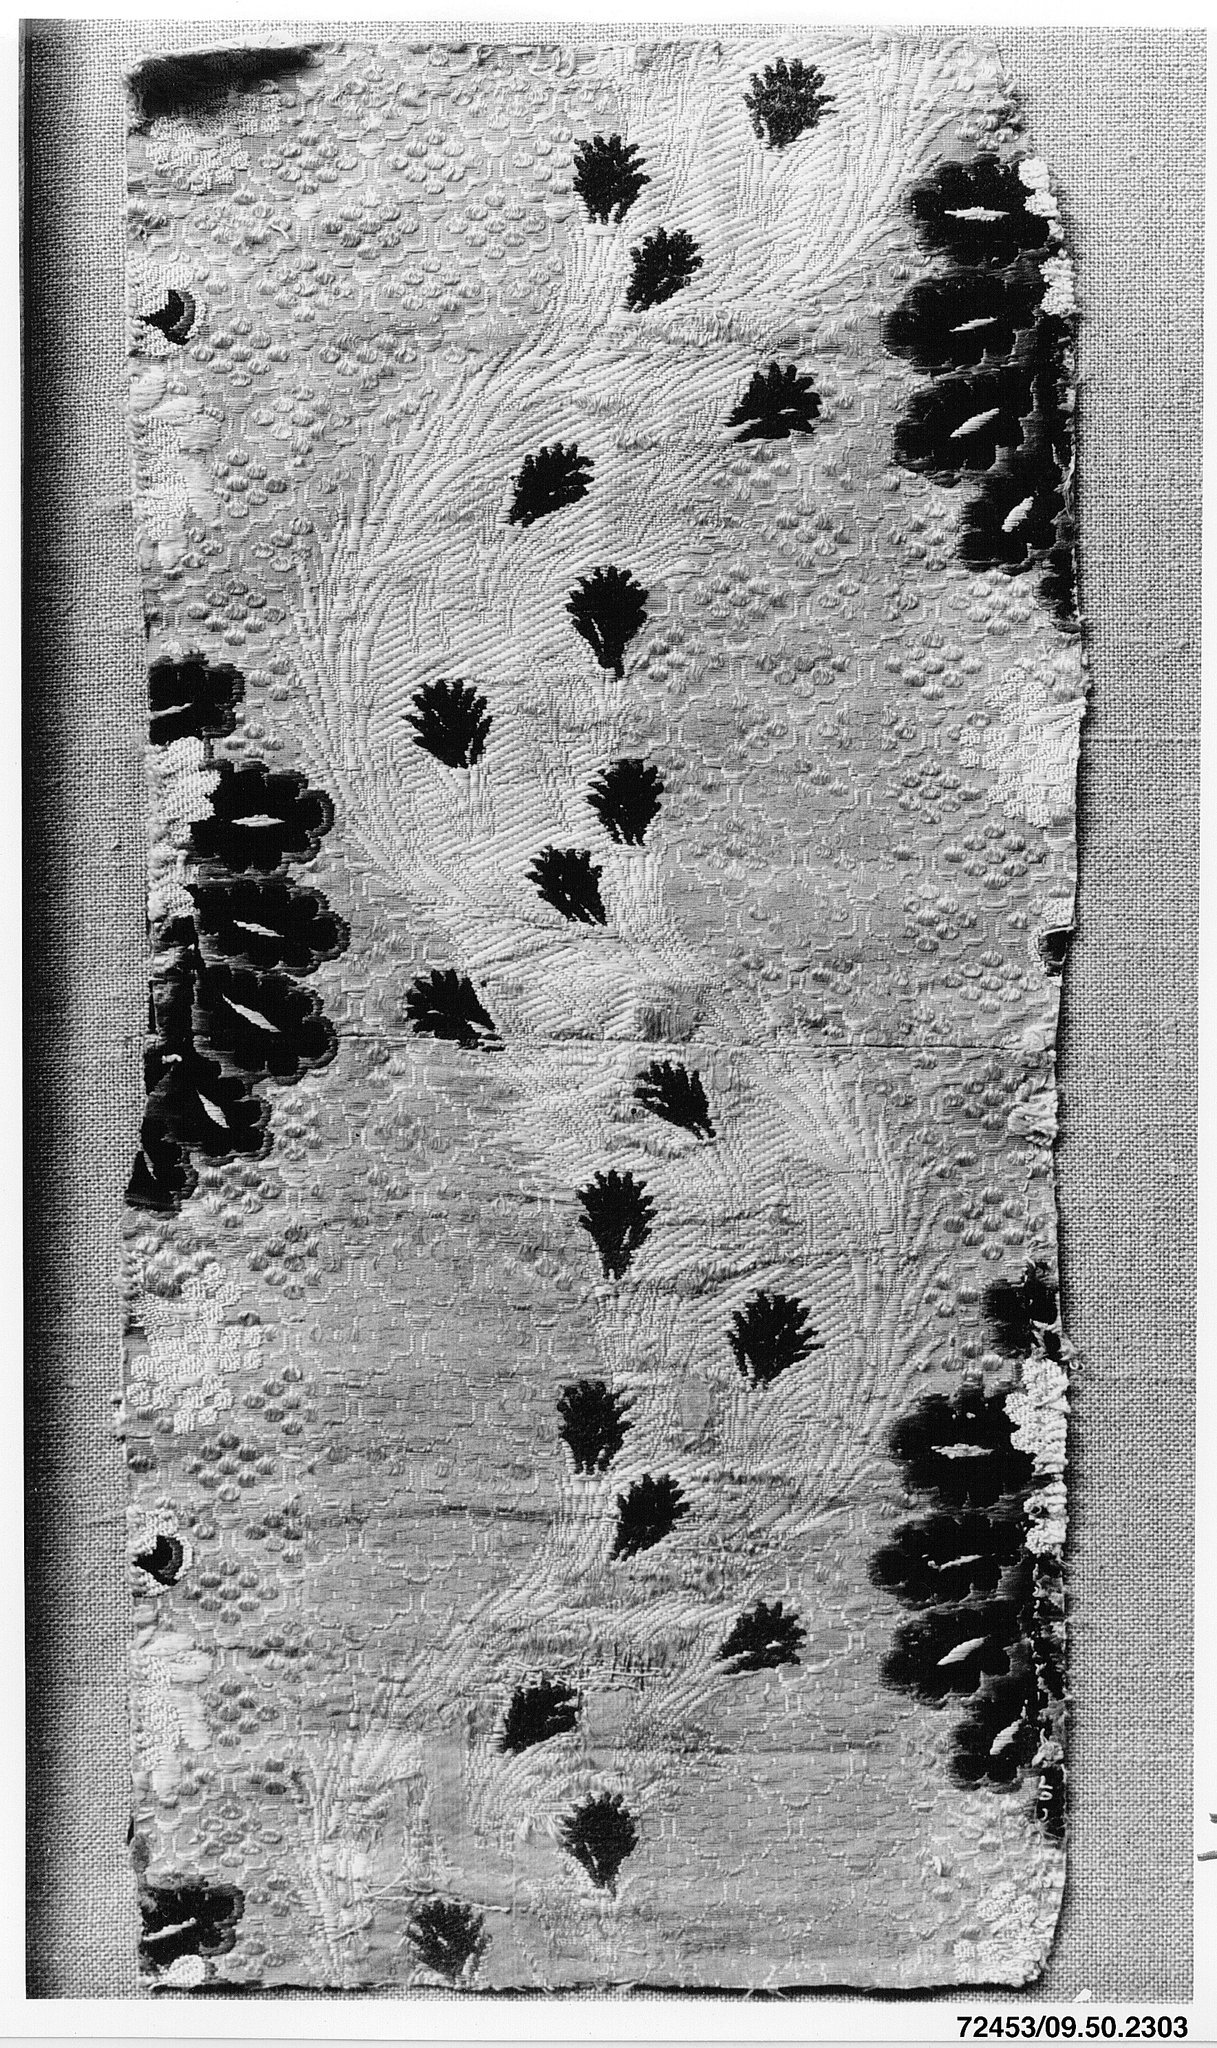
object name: piece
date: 1760-1770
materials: silk